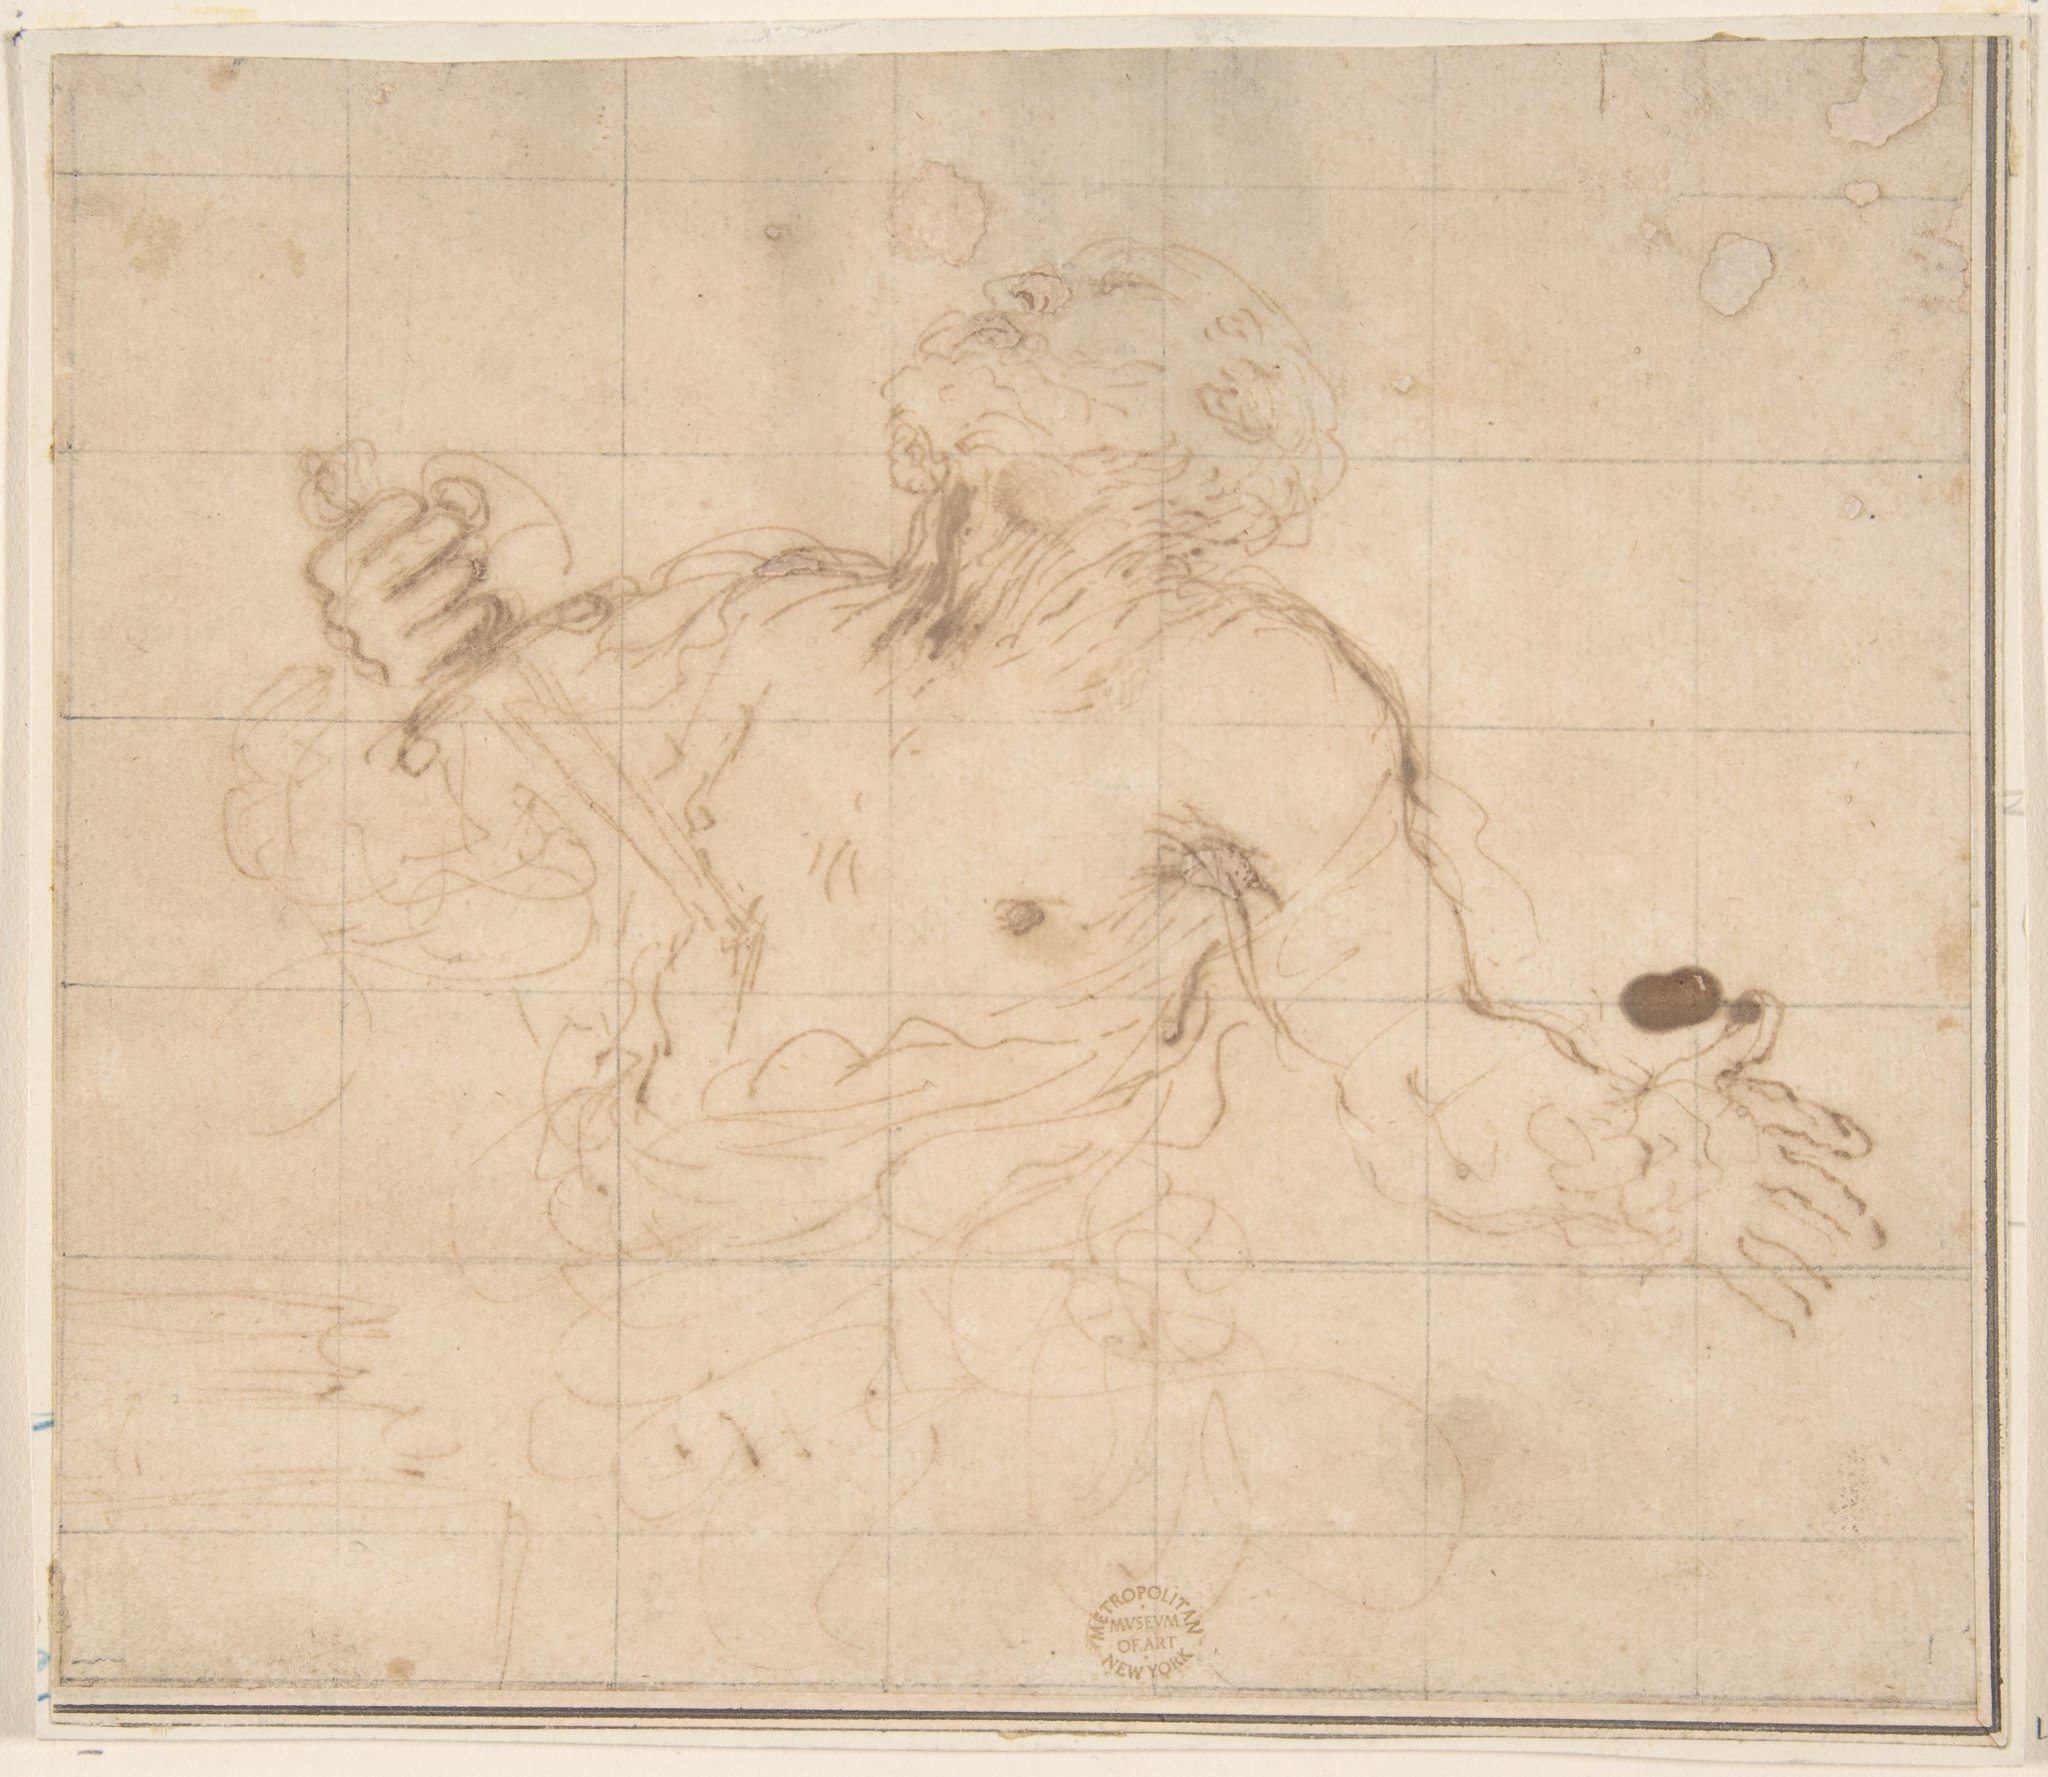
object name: drawing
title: Man Stabbing Himself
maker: guercino (giovanni francesco barbieri)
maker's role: artist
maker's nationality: italian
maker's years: 1591-1666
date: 1591-1666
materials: chalk, ink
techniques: pen, drawing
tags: knives,men